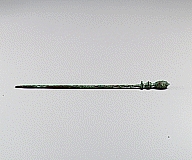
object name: pin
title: Bronze pin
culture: roman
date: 201-400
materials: bronze